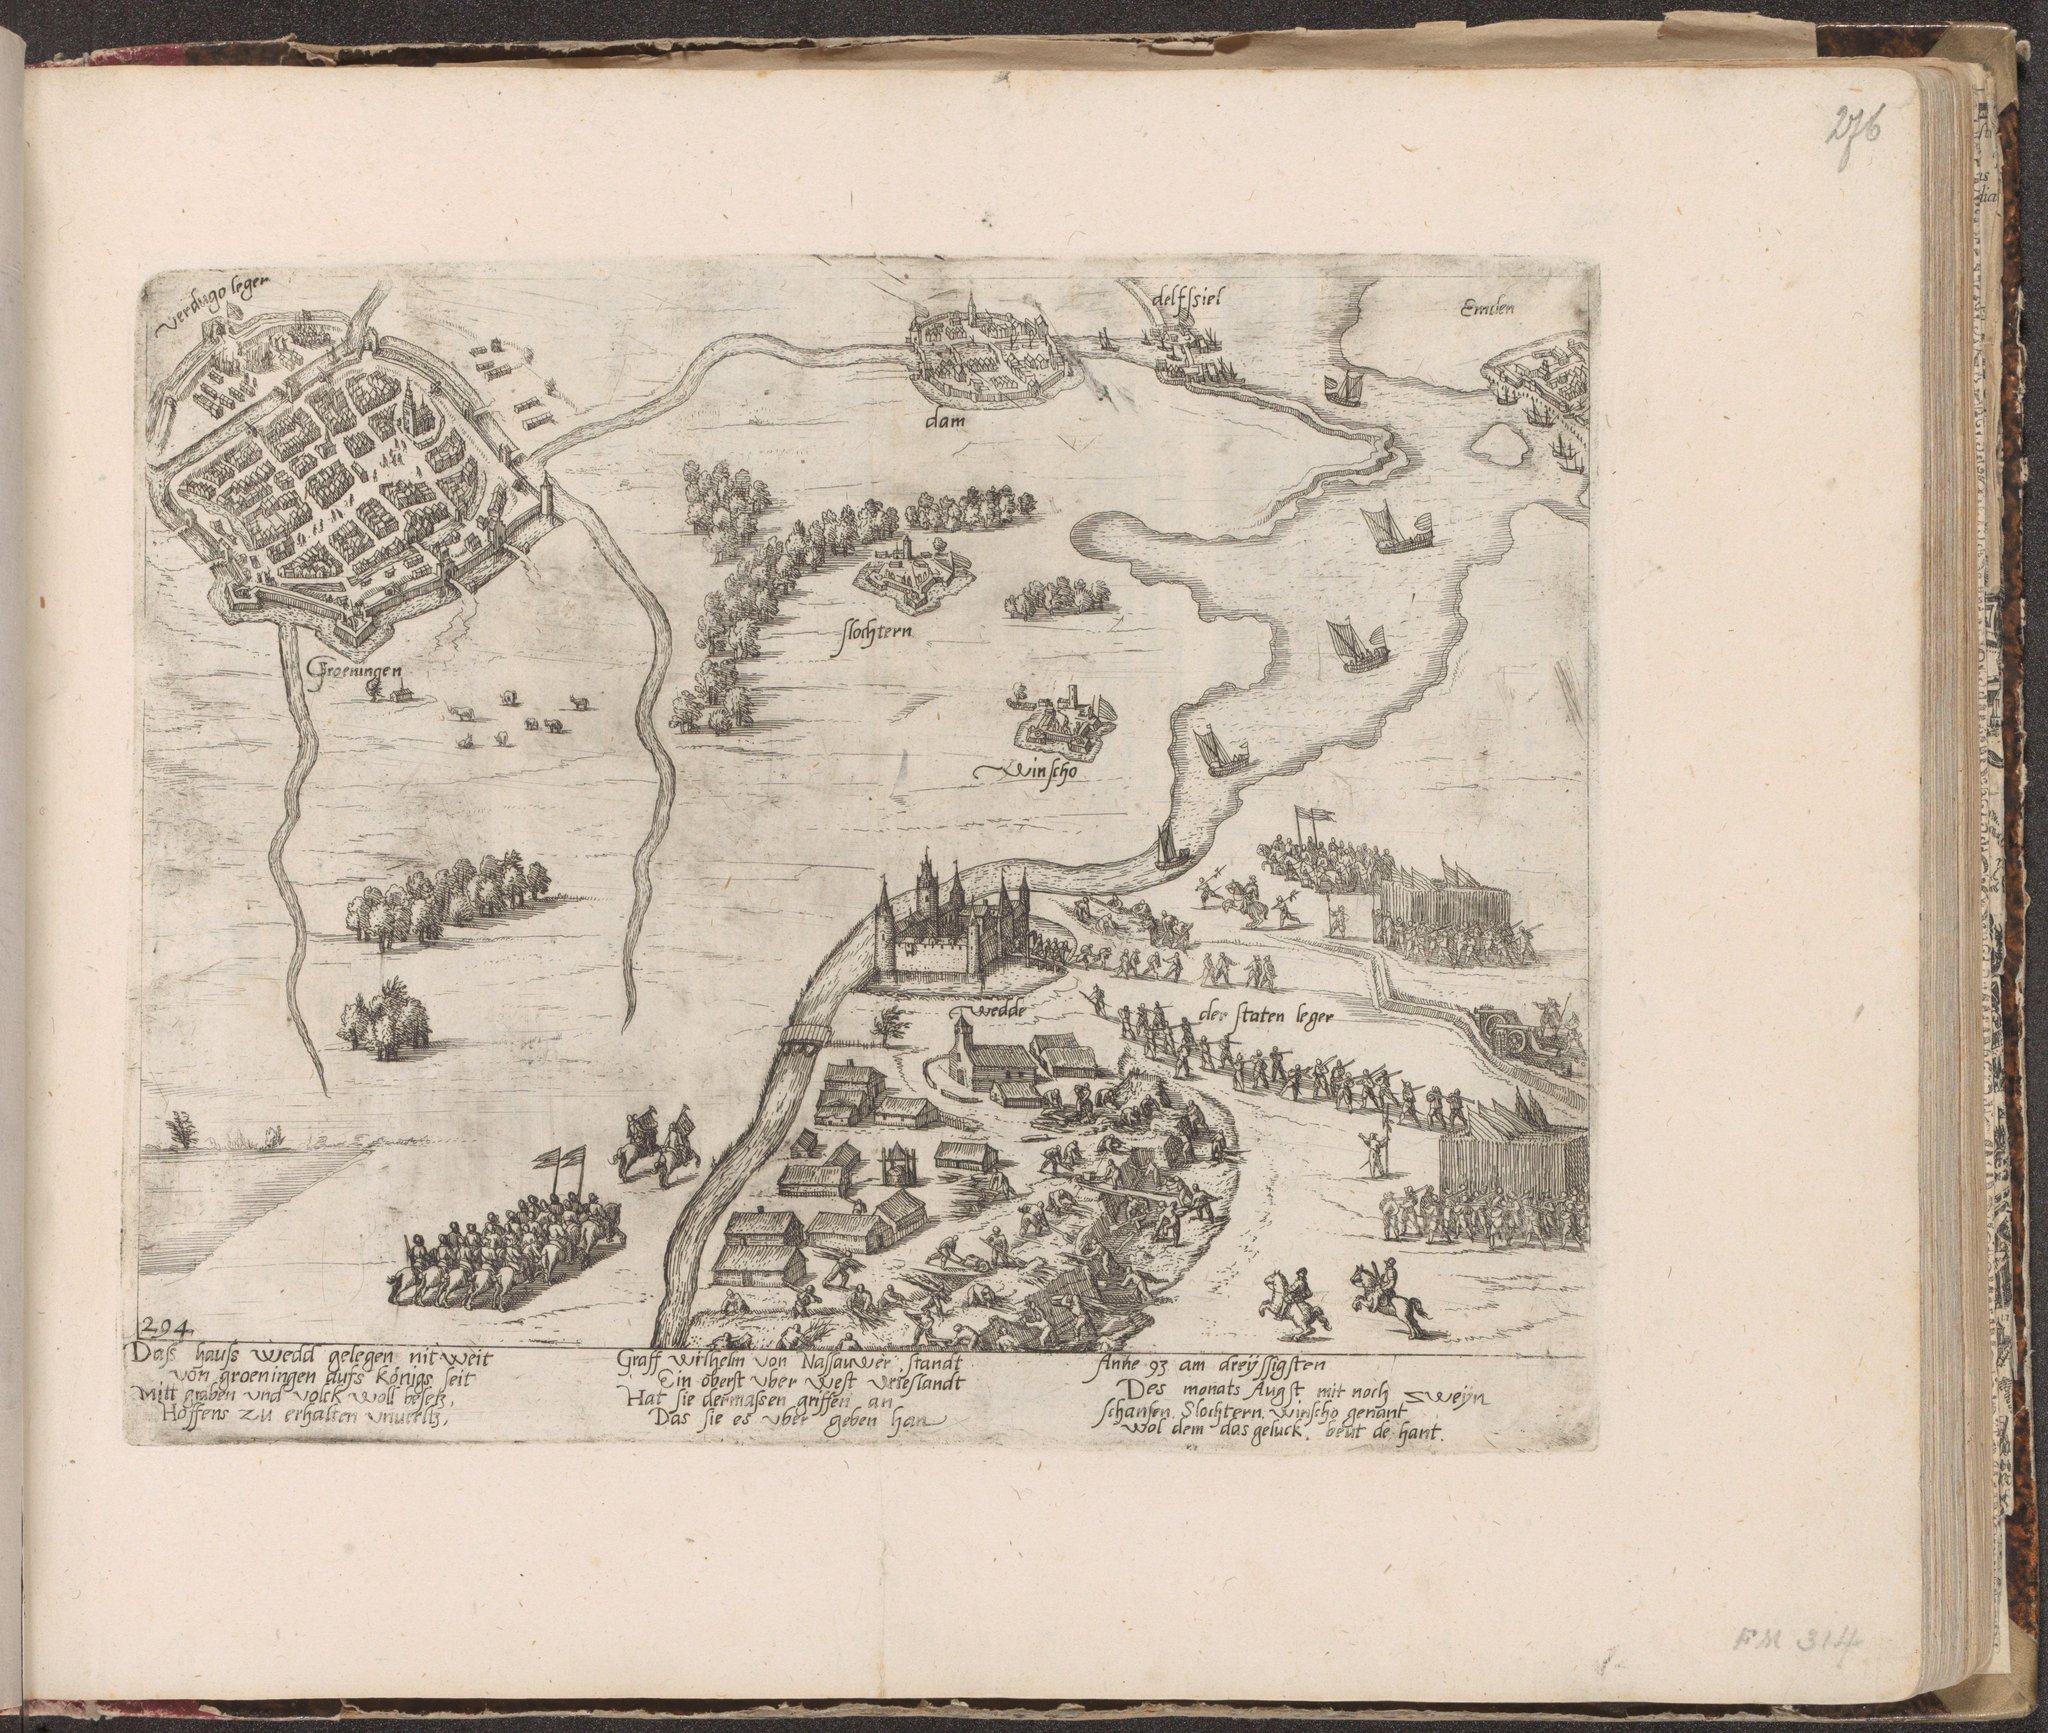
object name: history print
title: Verovering van schansen in de omgeving van Groningen, 1593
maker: frans hogenberg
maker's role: print maker, publisher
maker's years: 1538-1590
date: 1593-1595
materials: paper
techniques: etching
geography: cologne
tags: willem lodewijk graaf van nassau-dillenburg, fortifications, military engineering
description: Verovering van schansen in de omgeving van Groningen door het Staatse leger onder graaf Willem Lodewijk van Nassau, 30 augustus 1593. Gezicht op het gebied rond Groningen met de vestingen te Slochteren en Winschoten. De verdediging bij het Huis te Wedde wordt versterkt. Het leger van Verdugo gelegen boven Groningen. Met onderschrift van 12 regels in het Duits. Linksonder genummerd: 294. De prent maakt deel uit van een album.